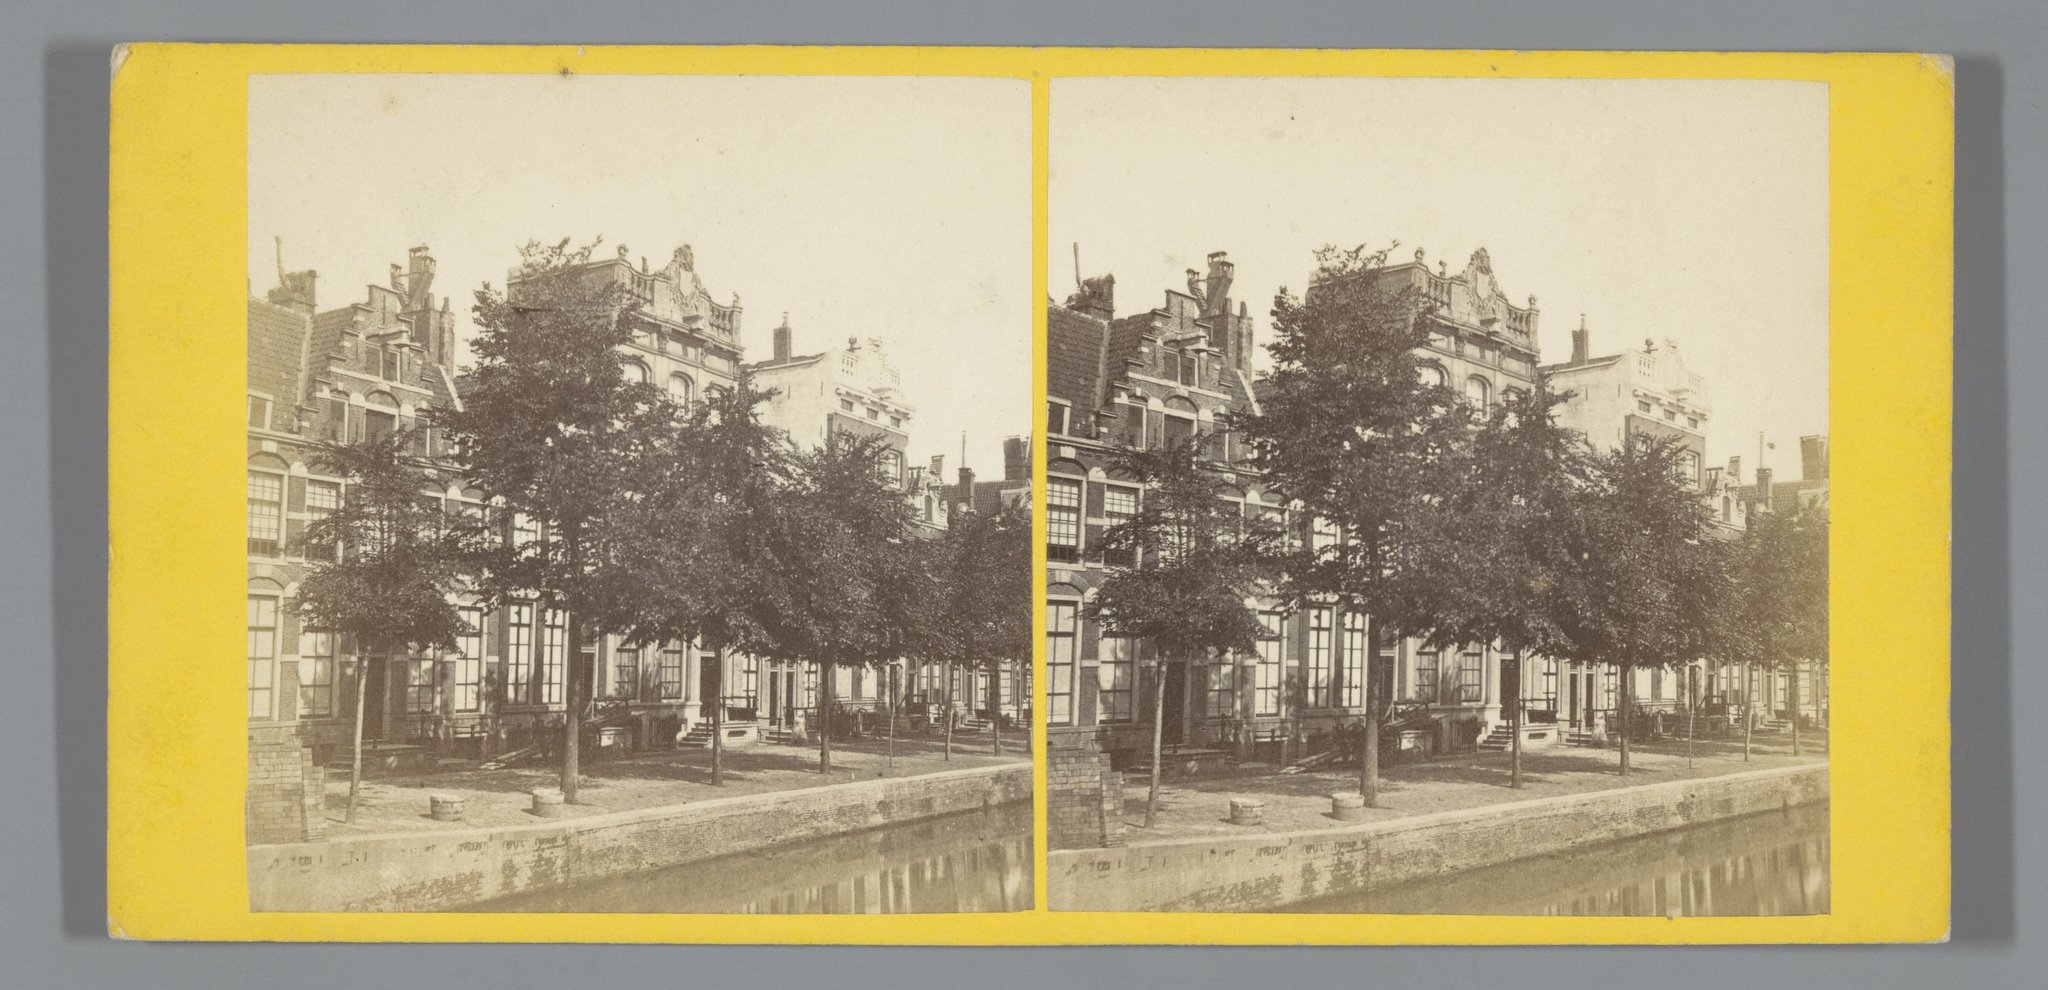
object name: stereograph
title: Gezicht op de Herengracht bij de Huidenstraat in Amsterdam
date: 1860-1885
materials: cardboard, photographic support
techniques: albumen print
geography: amsterdam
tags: street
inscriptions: number: ‘4.5’, inscription: ‘De Heerengracht bij de Huidenstraat.’